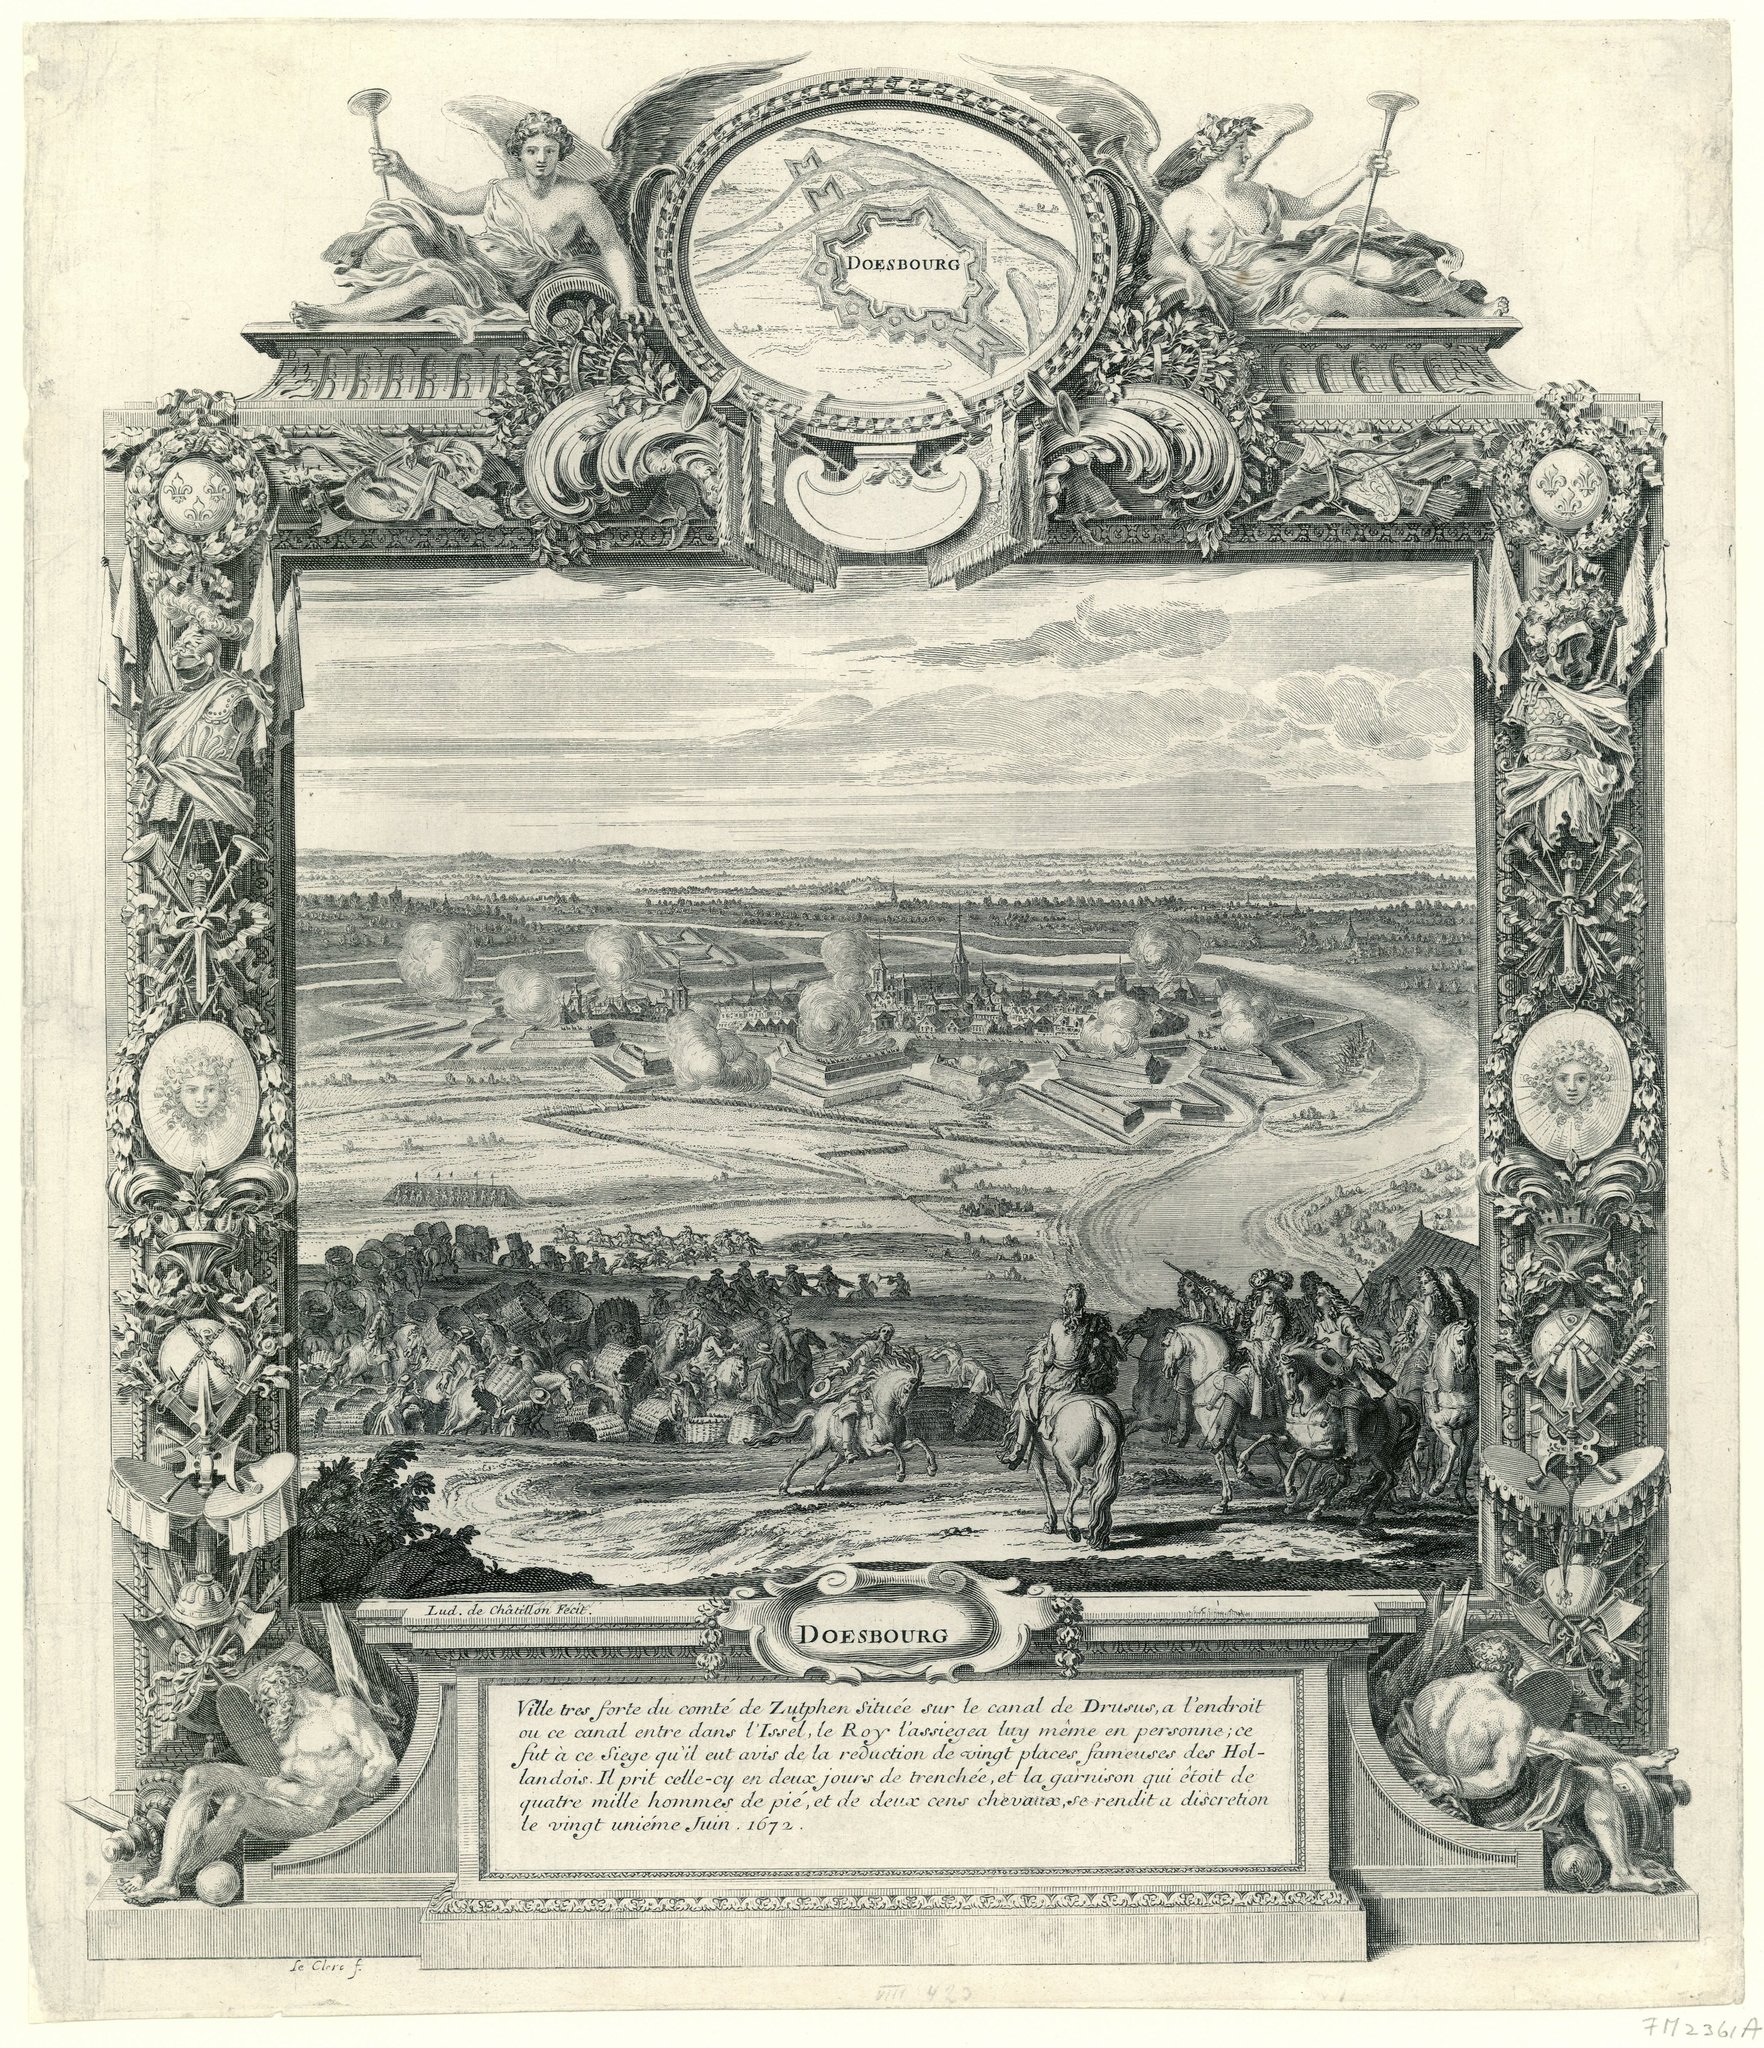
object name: history print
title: Grandes Conquêtes du Roi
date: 1683-1694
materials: paper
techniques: engraving, etching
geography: france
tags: lodewijk xiv (koning van frankrijk), capture of city (after the siege)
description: De verovering van de versterkte stad Doesburg door de Franse legers op 21 juni 1672. De prent maakt deel uit van een Franse reeks van 28 prenten met de veroveringen van de Franse koning Lodewijk XIV tussen 1672 en 1678 getiteld: Grandes Conquêtes du Roi. In een ornamentele omlijsting met bovenaan een plattegrond van de versterkingen van de stad, verder wapens, delen van wapenrustingen en geboeide gevangenen. Onderaan een cartouche met opschrift van 6 regels in het Frans.